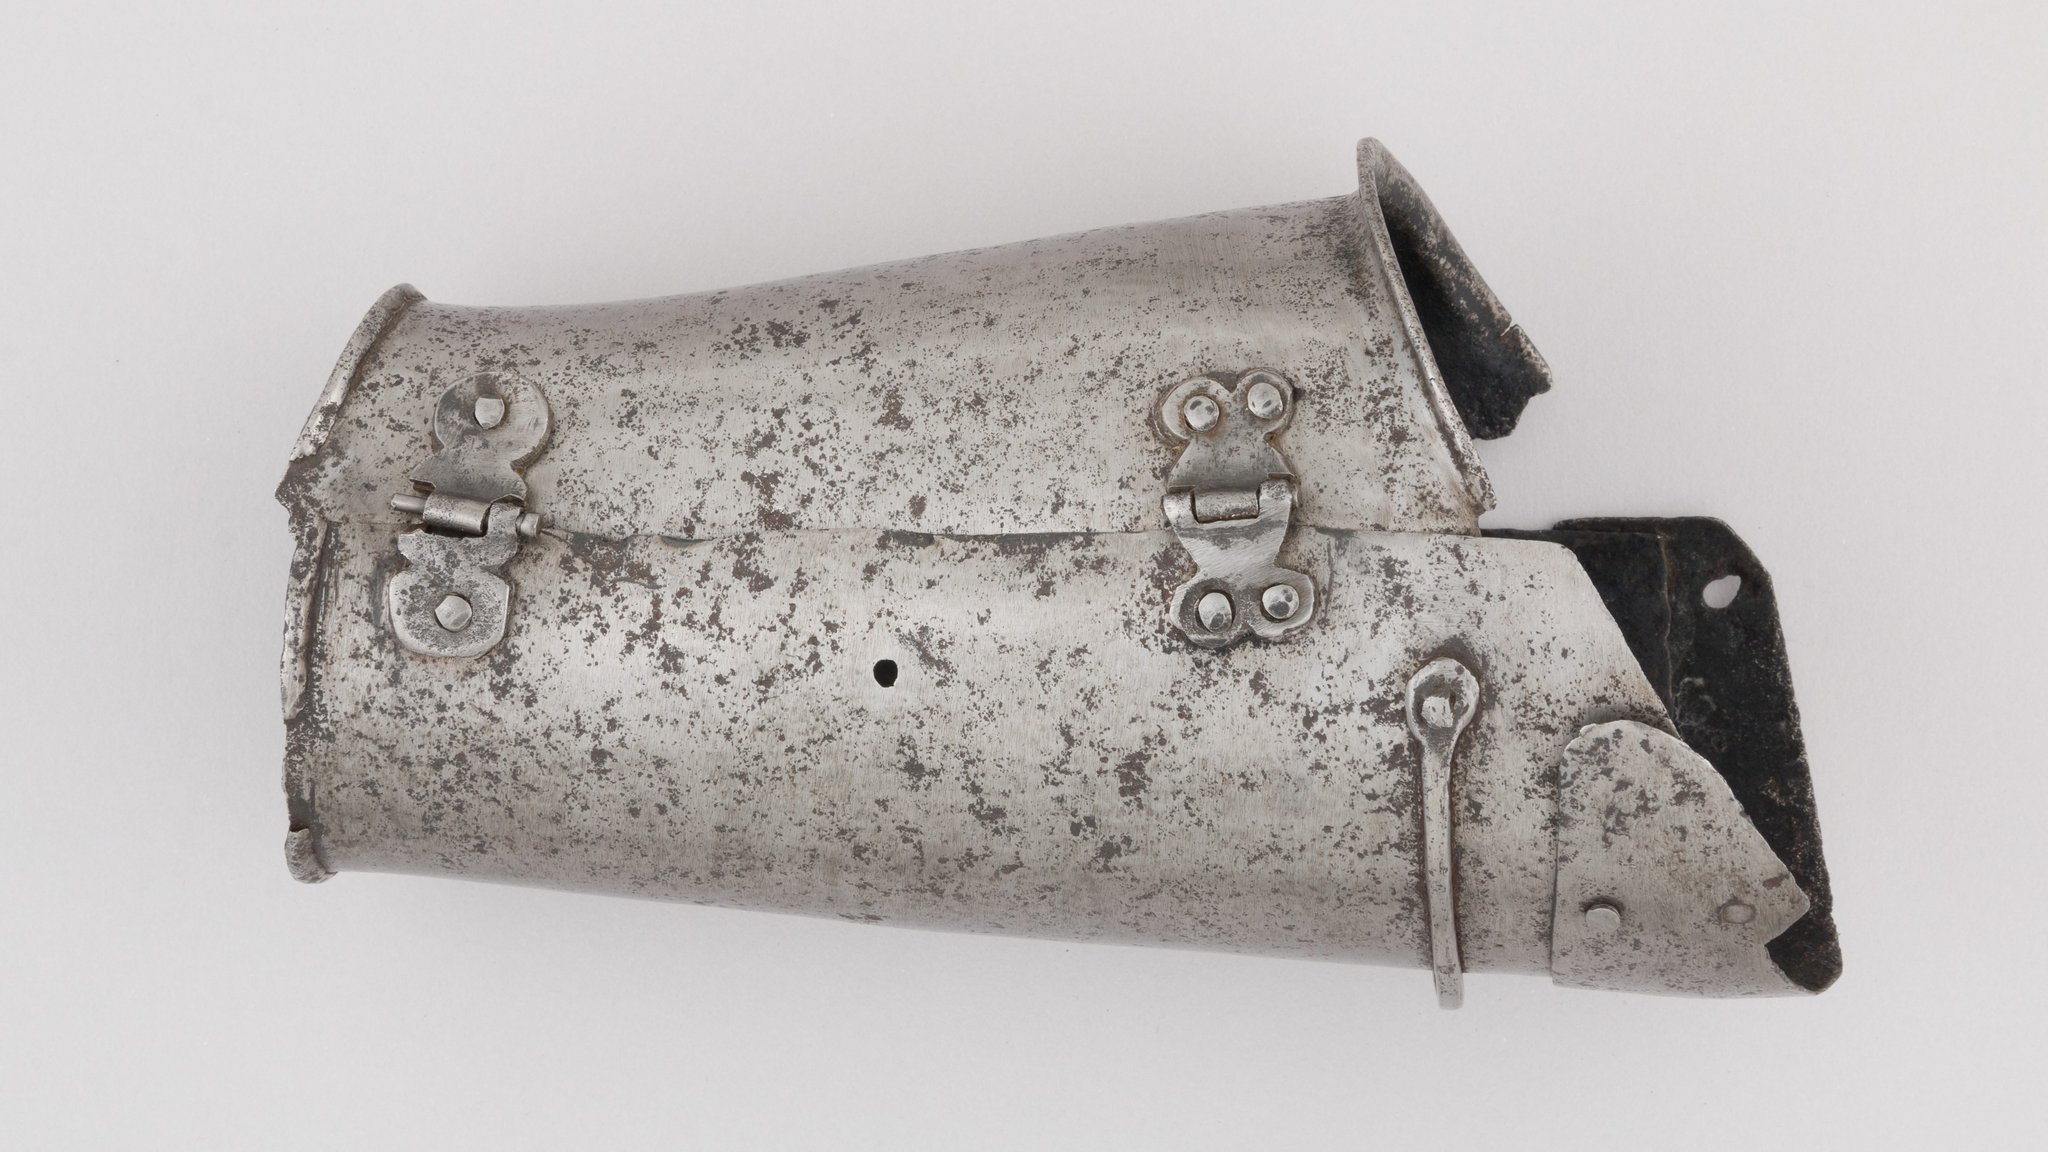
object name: forearm defense vambrace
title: Forearm Defense (Vambrace)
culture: italian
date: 1430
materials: steel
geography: italy